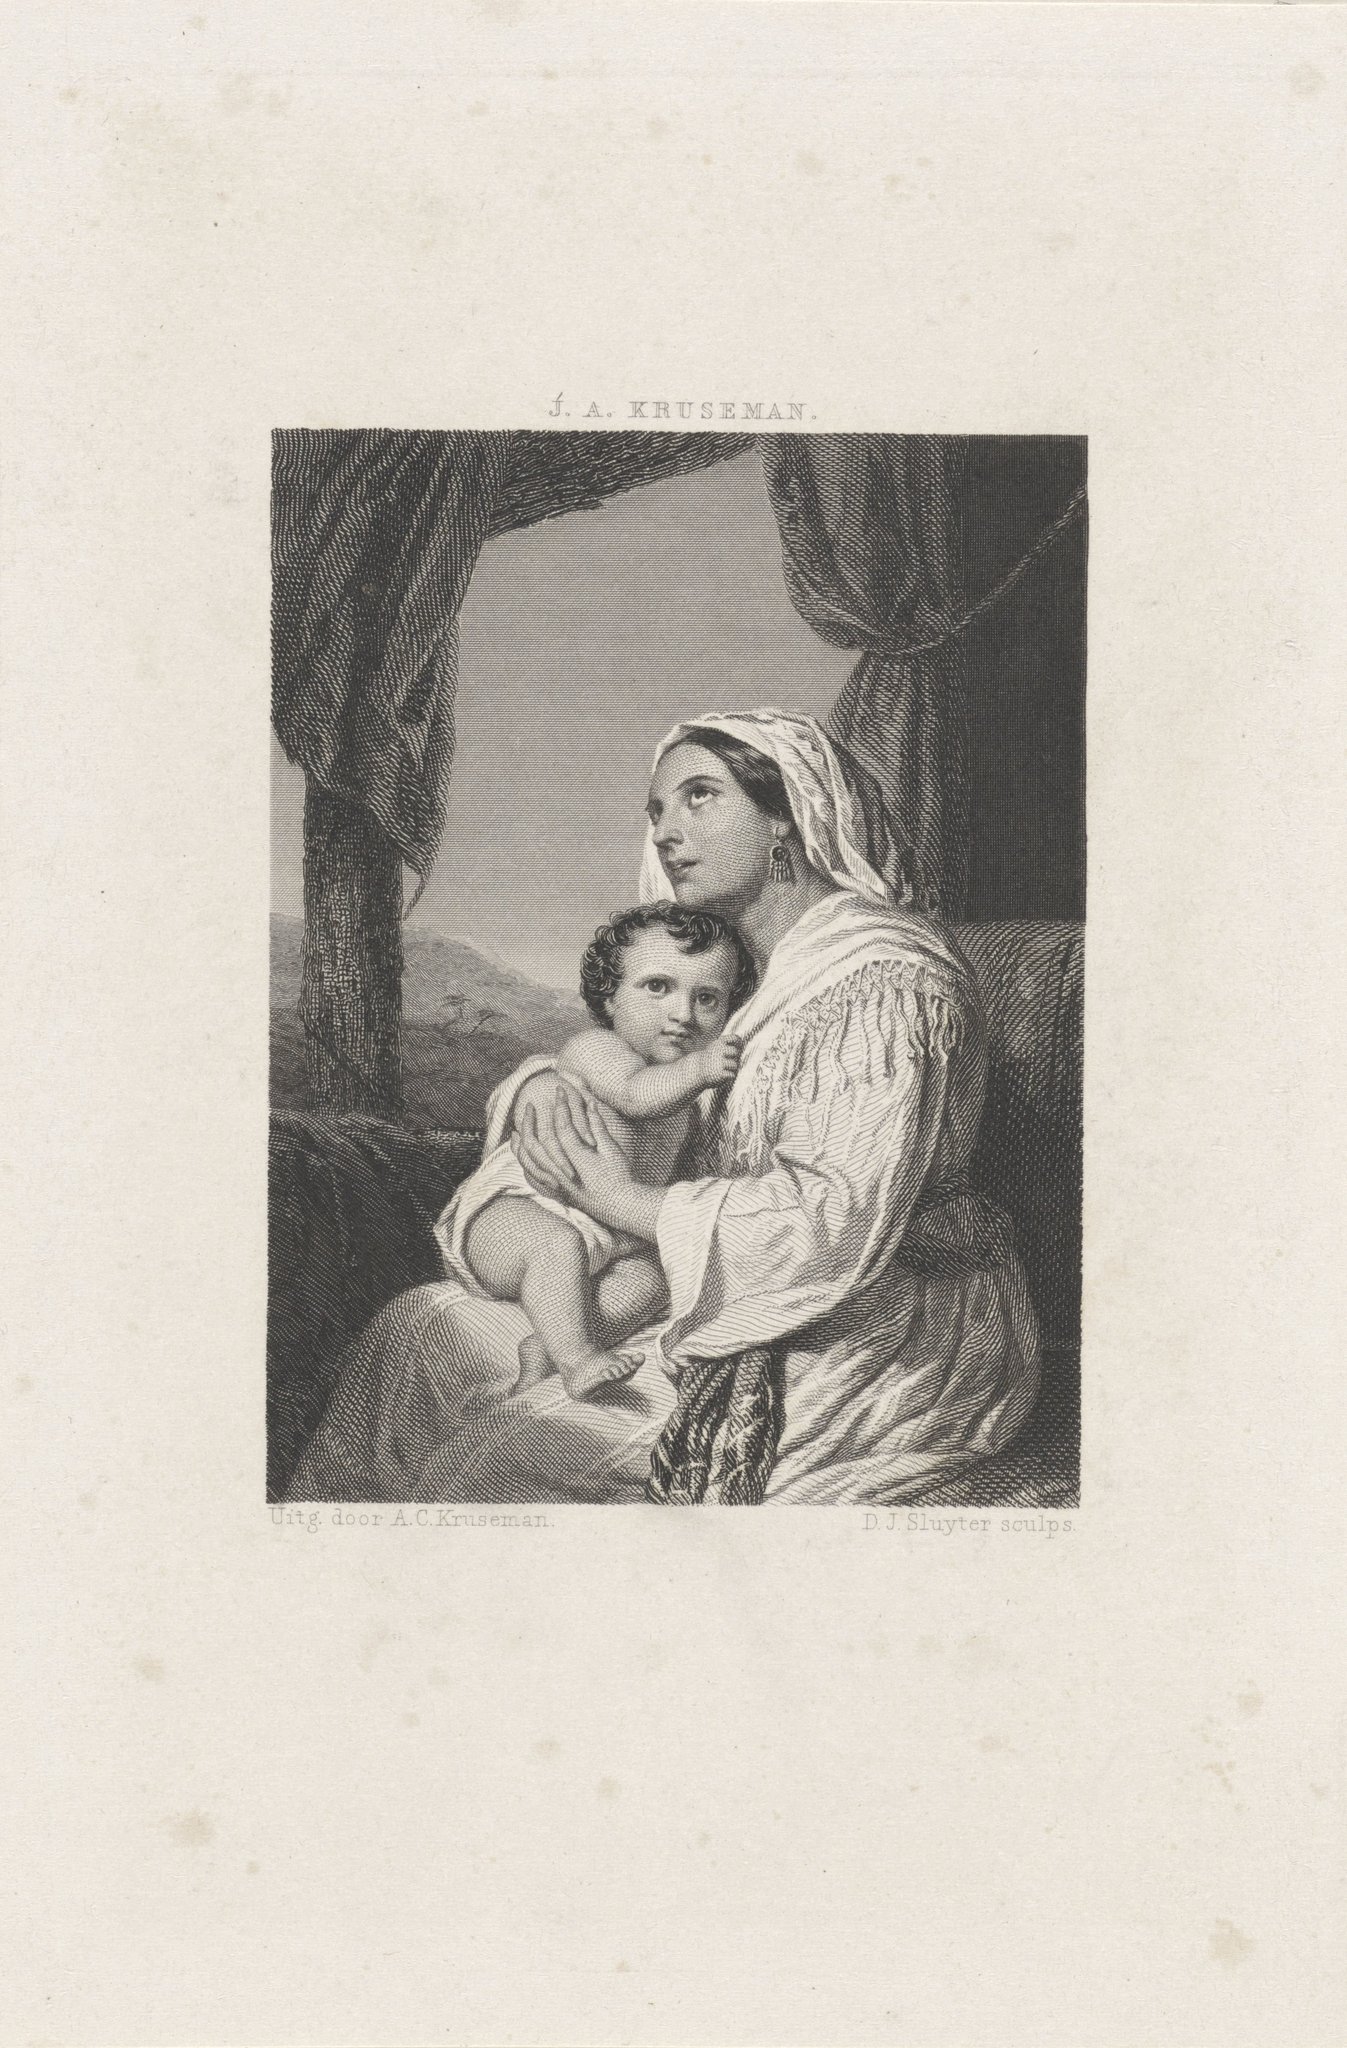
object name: book illustration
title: Moeder en kind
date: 1860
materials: paper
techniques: engraving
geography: amsterdam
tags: mary sitting or enthroned, the christ-child sitting on her knee (christ-child to mary's left) - ff - the christ-child to mary's right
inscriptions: inscription: ‘Aurora 1860.’, collector's mark: Lugt 2228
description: Prent komt voor in: S.J. van den Bergh (red.). Aurora; jaarboekje voor 1860. Haarlem: A.C. Kruseman, 1860.